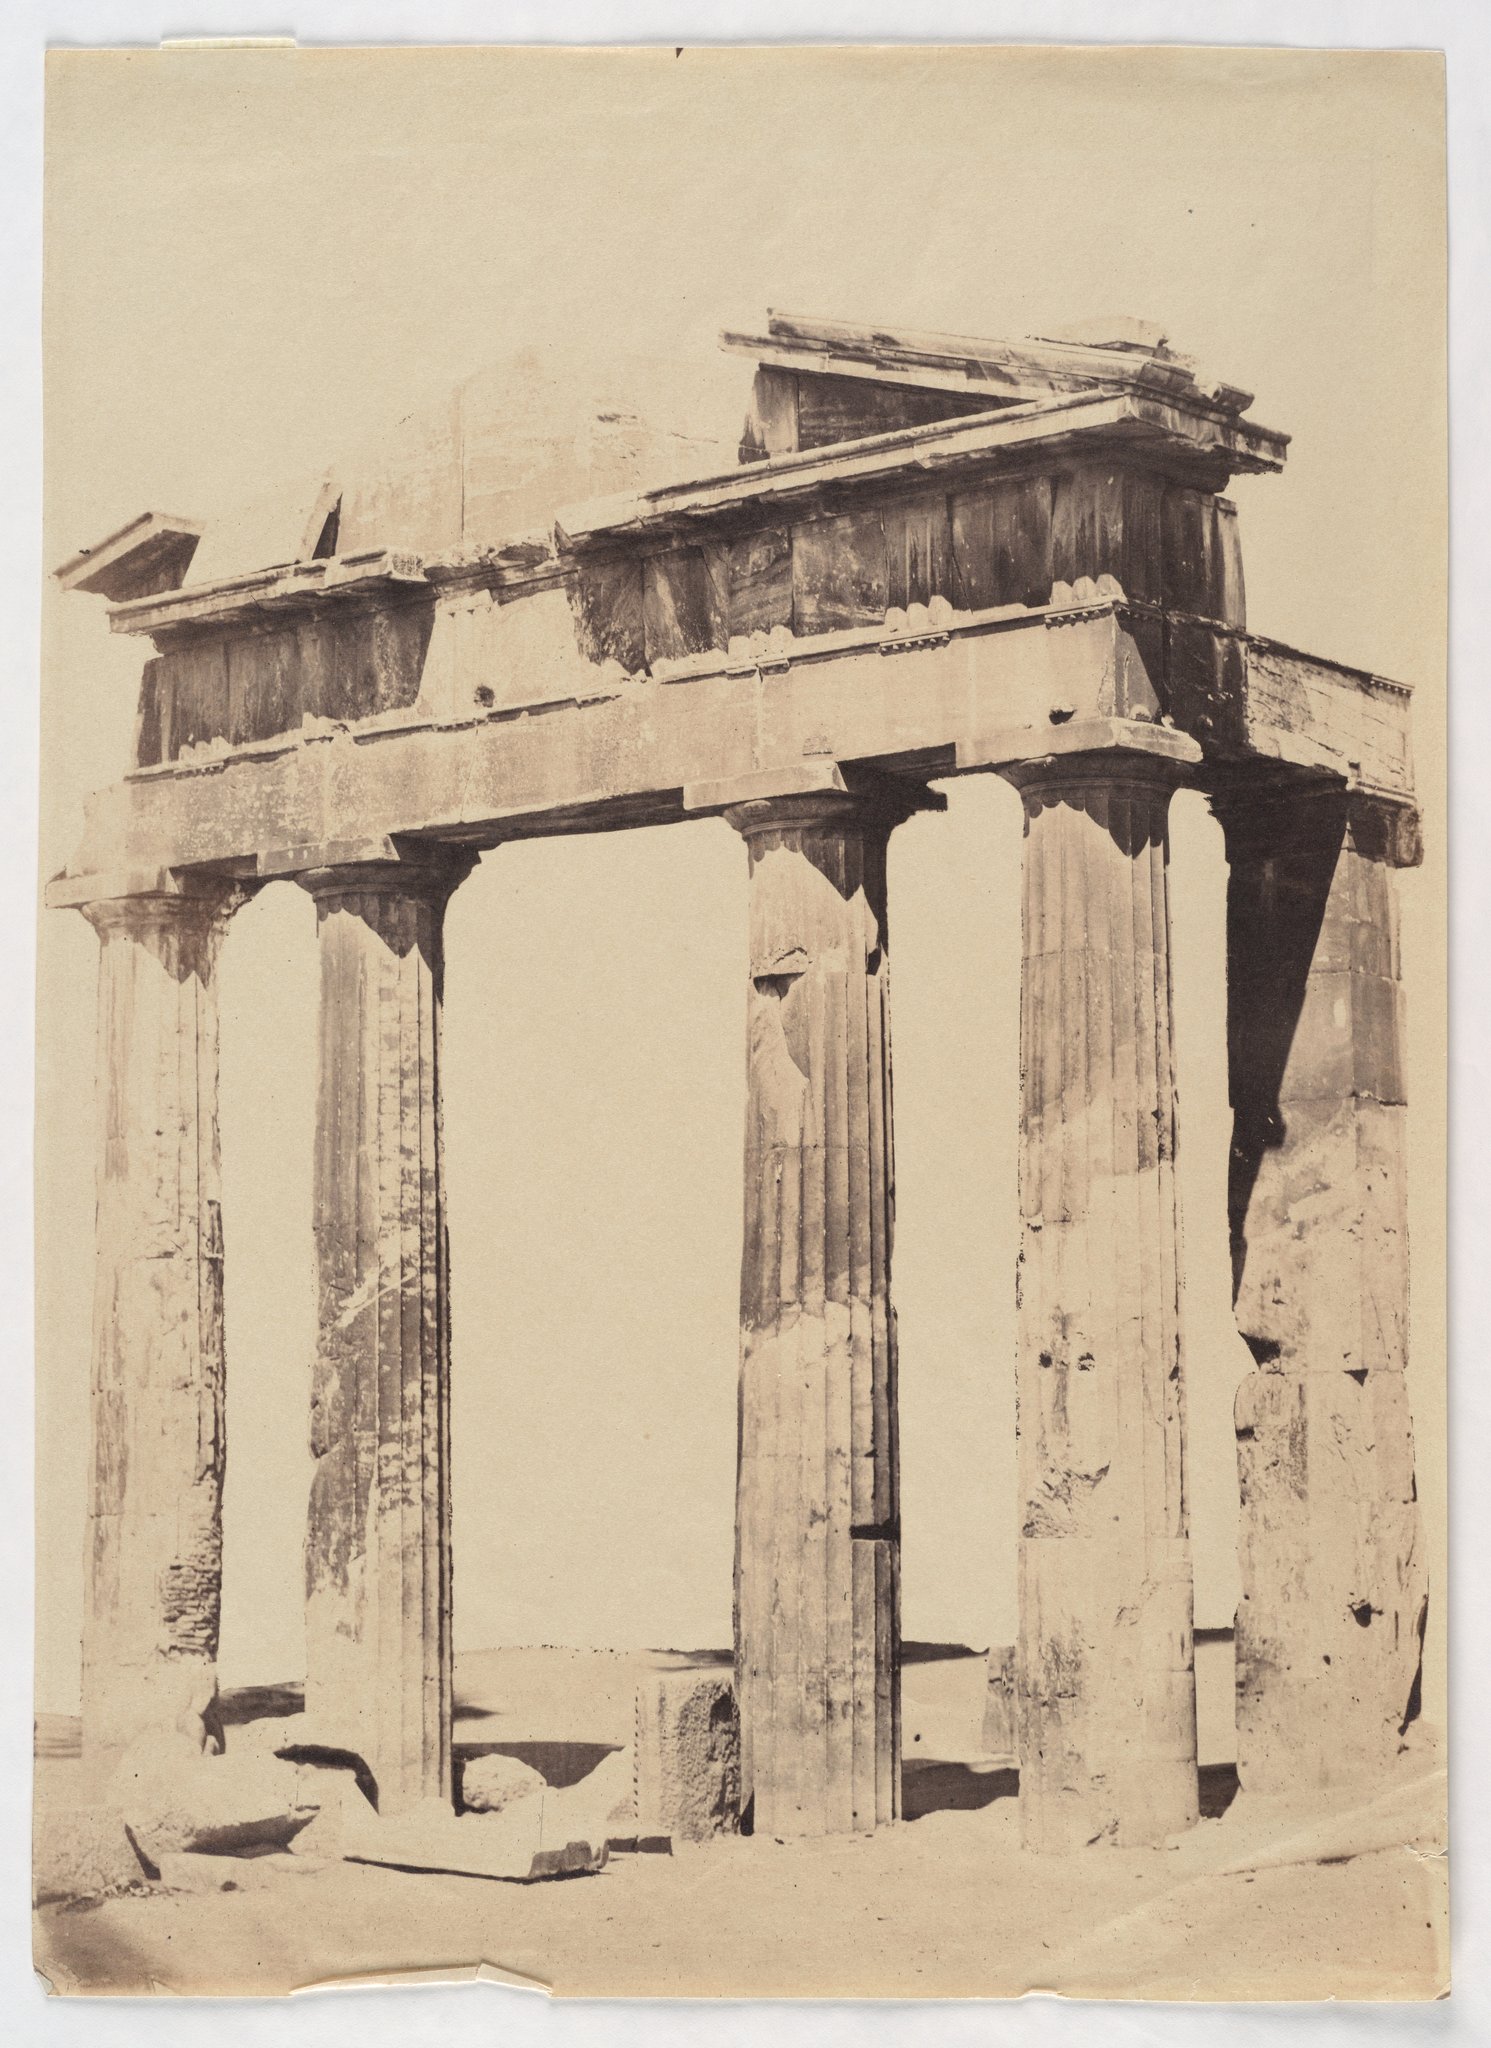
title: [Acropolis, Athens, Greece]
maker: james robertson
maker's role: artist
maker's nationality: british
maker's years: 1813-1881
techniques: salted paper print